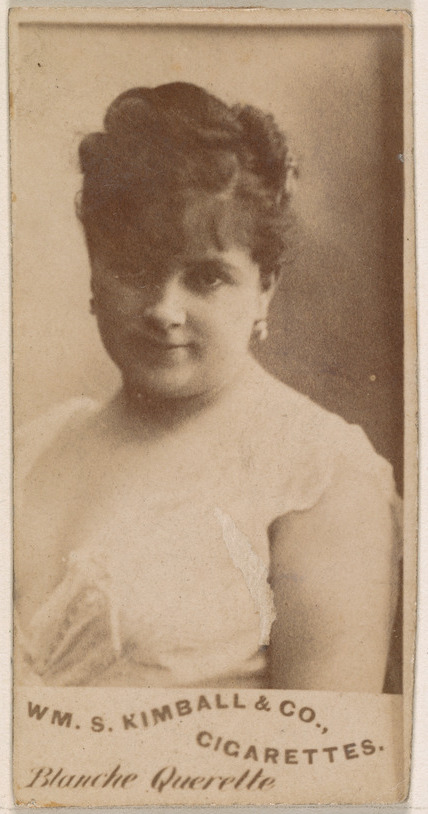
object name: photograph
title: Blanche Querrette, from the Actresses series (N203) issued by Wm. S. Kimball & Co.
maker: william s. kimball & company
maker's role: publisher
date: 1889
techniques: color lithograph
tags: portraits,women,actresses